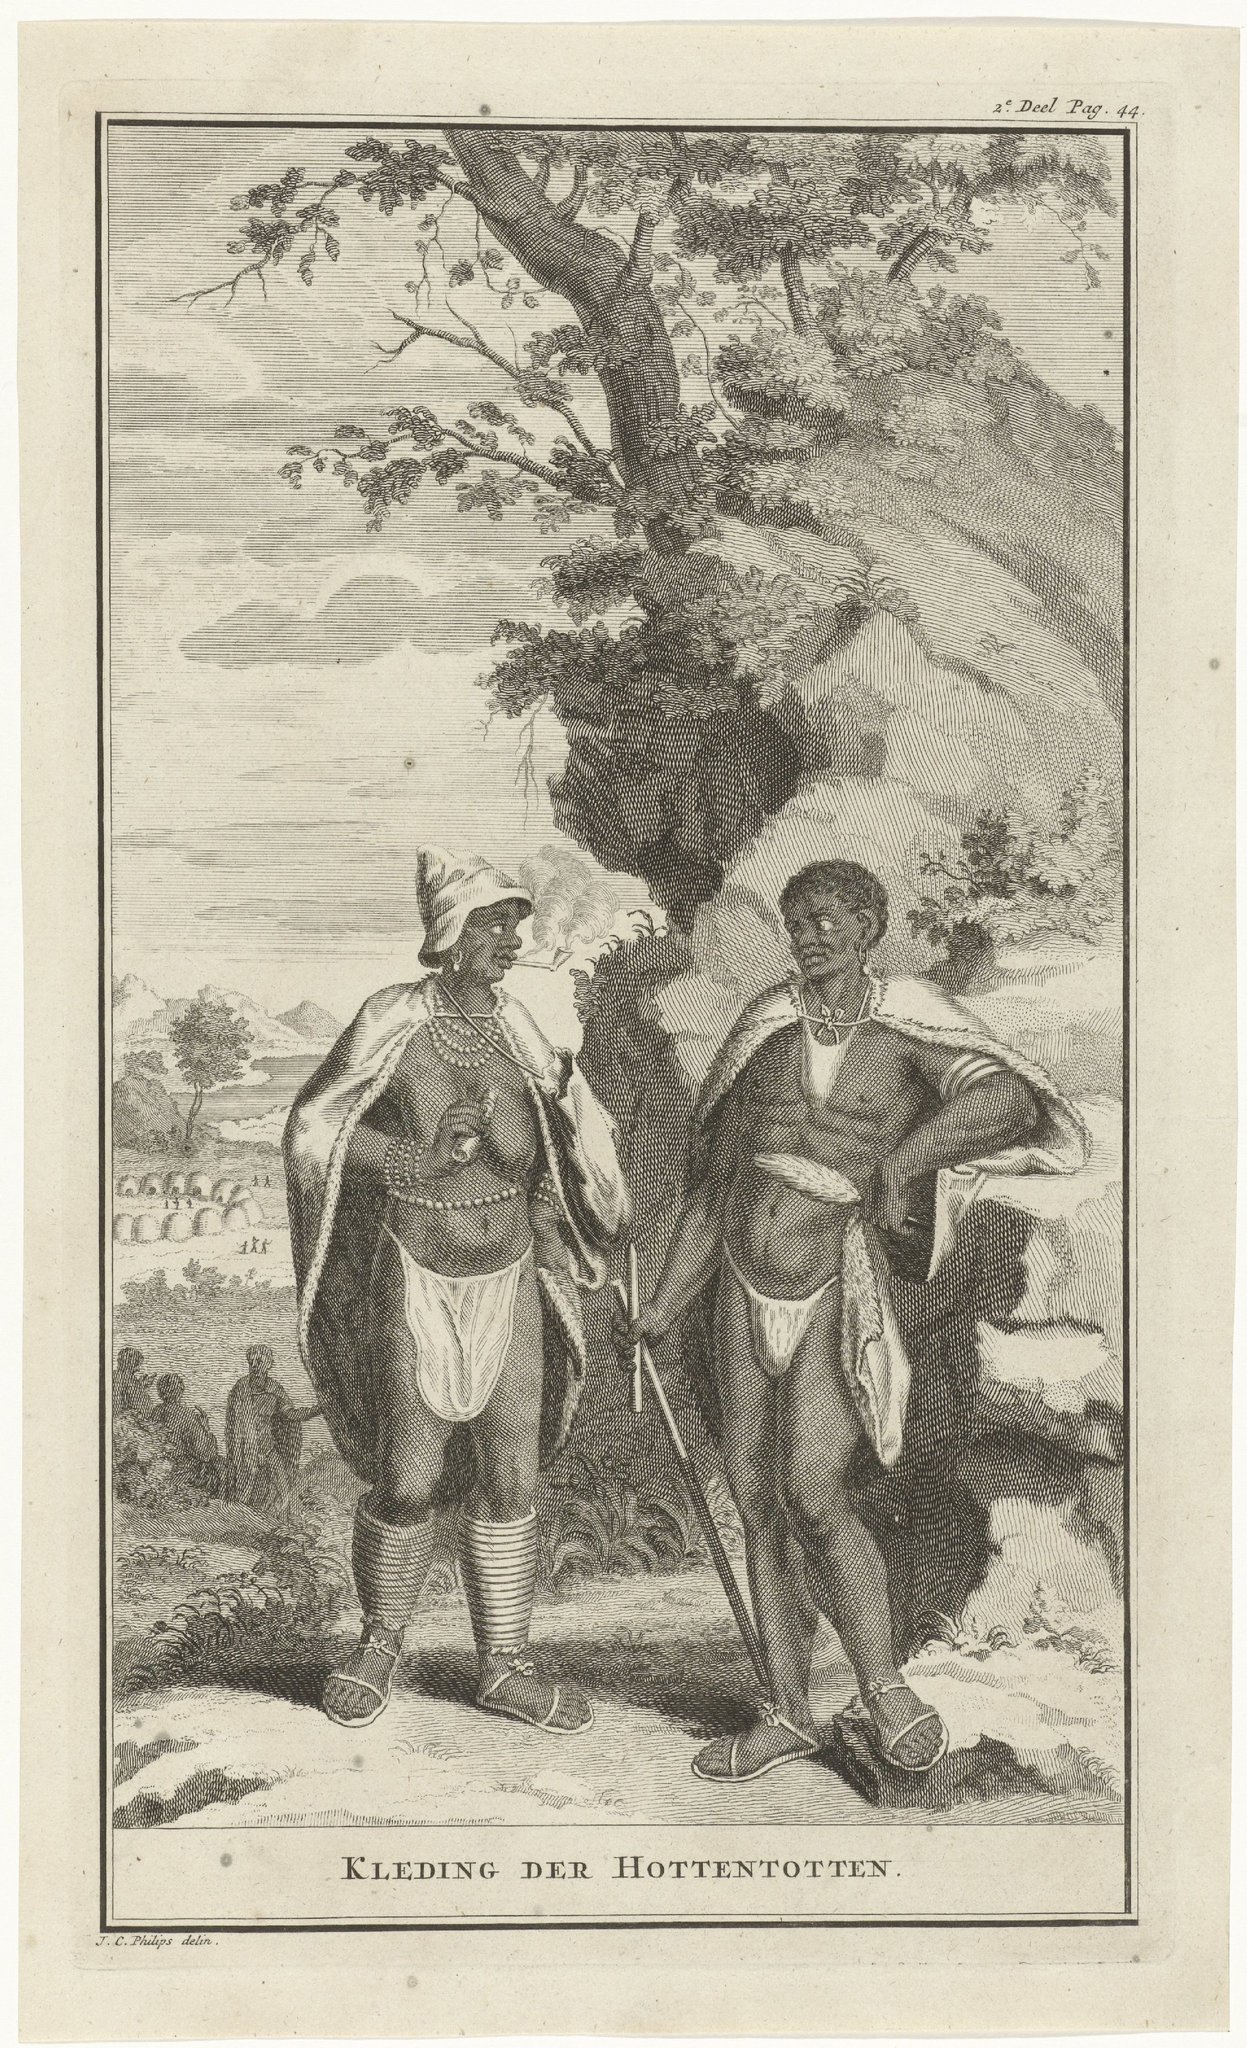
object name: book illustration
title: Kleding der Hottentotten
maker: jan caspar philips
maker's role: draughtsman, print maker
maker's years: 1700-1775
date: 1727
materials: paper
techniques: engraving, etching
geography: amsterdam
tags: folk costume, regional costume, khoikhoi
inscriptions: collector's mark: Lugt 2228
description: Prent als illustratie gebruikt in: Kolbe, Peter. Naaukeurige en uitvoerige beschryving van de kaap de Goede Hoop; behelzende een zeer omstandig verhaal van den tegenwoordigen toestant van dat vermaarde gewest ... beschryving van de oorsprong der Hottentotten, deel II, p. 44. Amsterdam: Balthazar Lakeman, 1727.